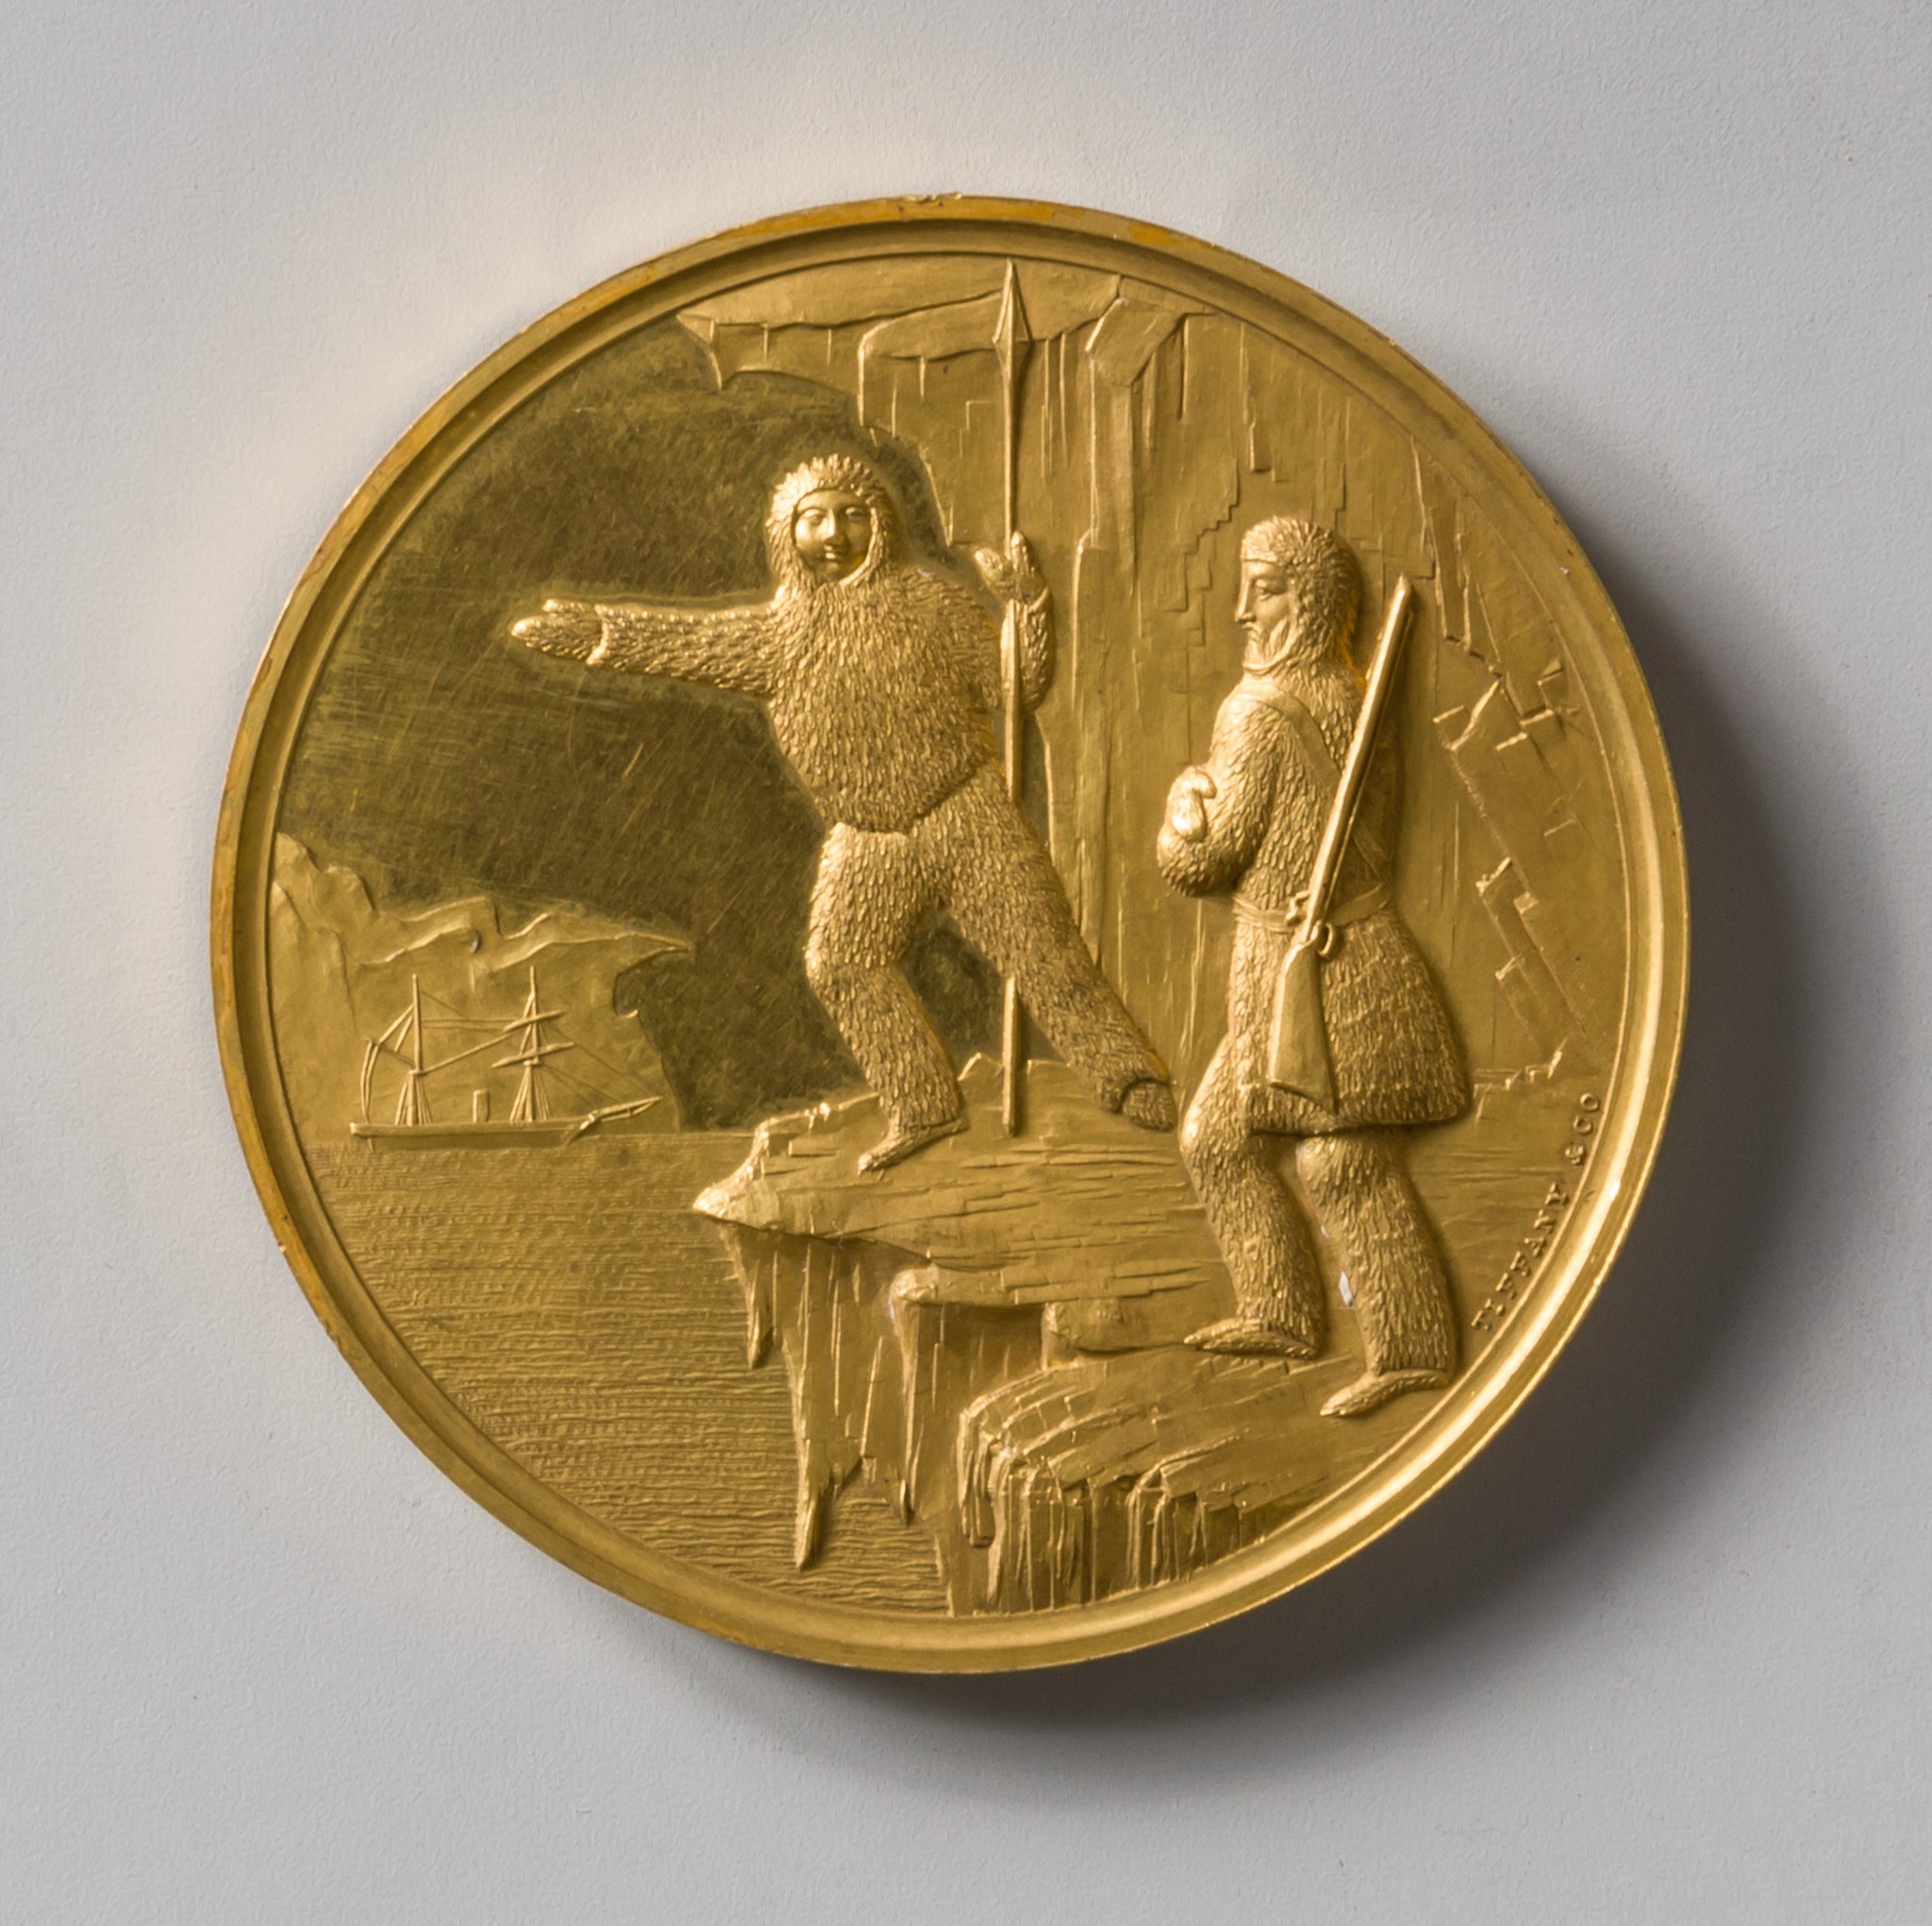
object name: medal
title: Awarded by the State of New York to Commander Hartstene for His Successful Rescue of Dr. Kane.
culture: american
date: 1857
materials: gold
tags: weapons,men,women,boats